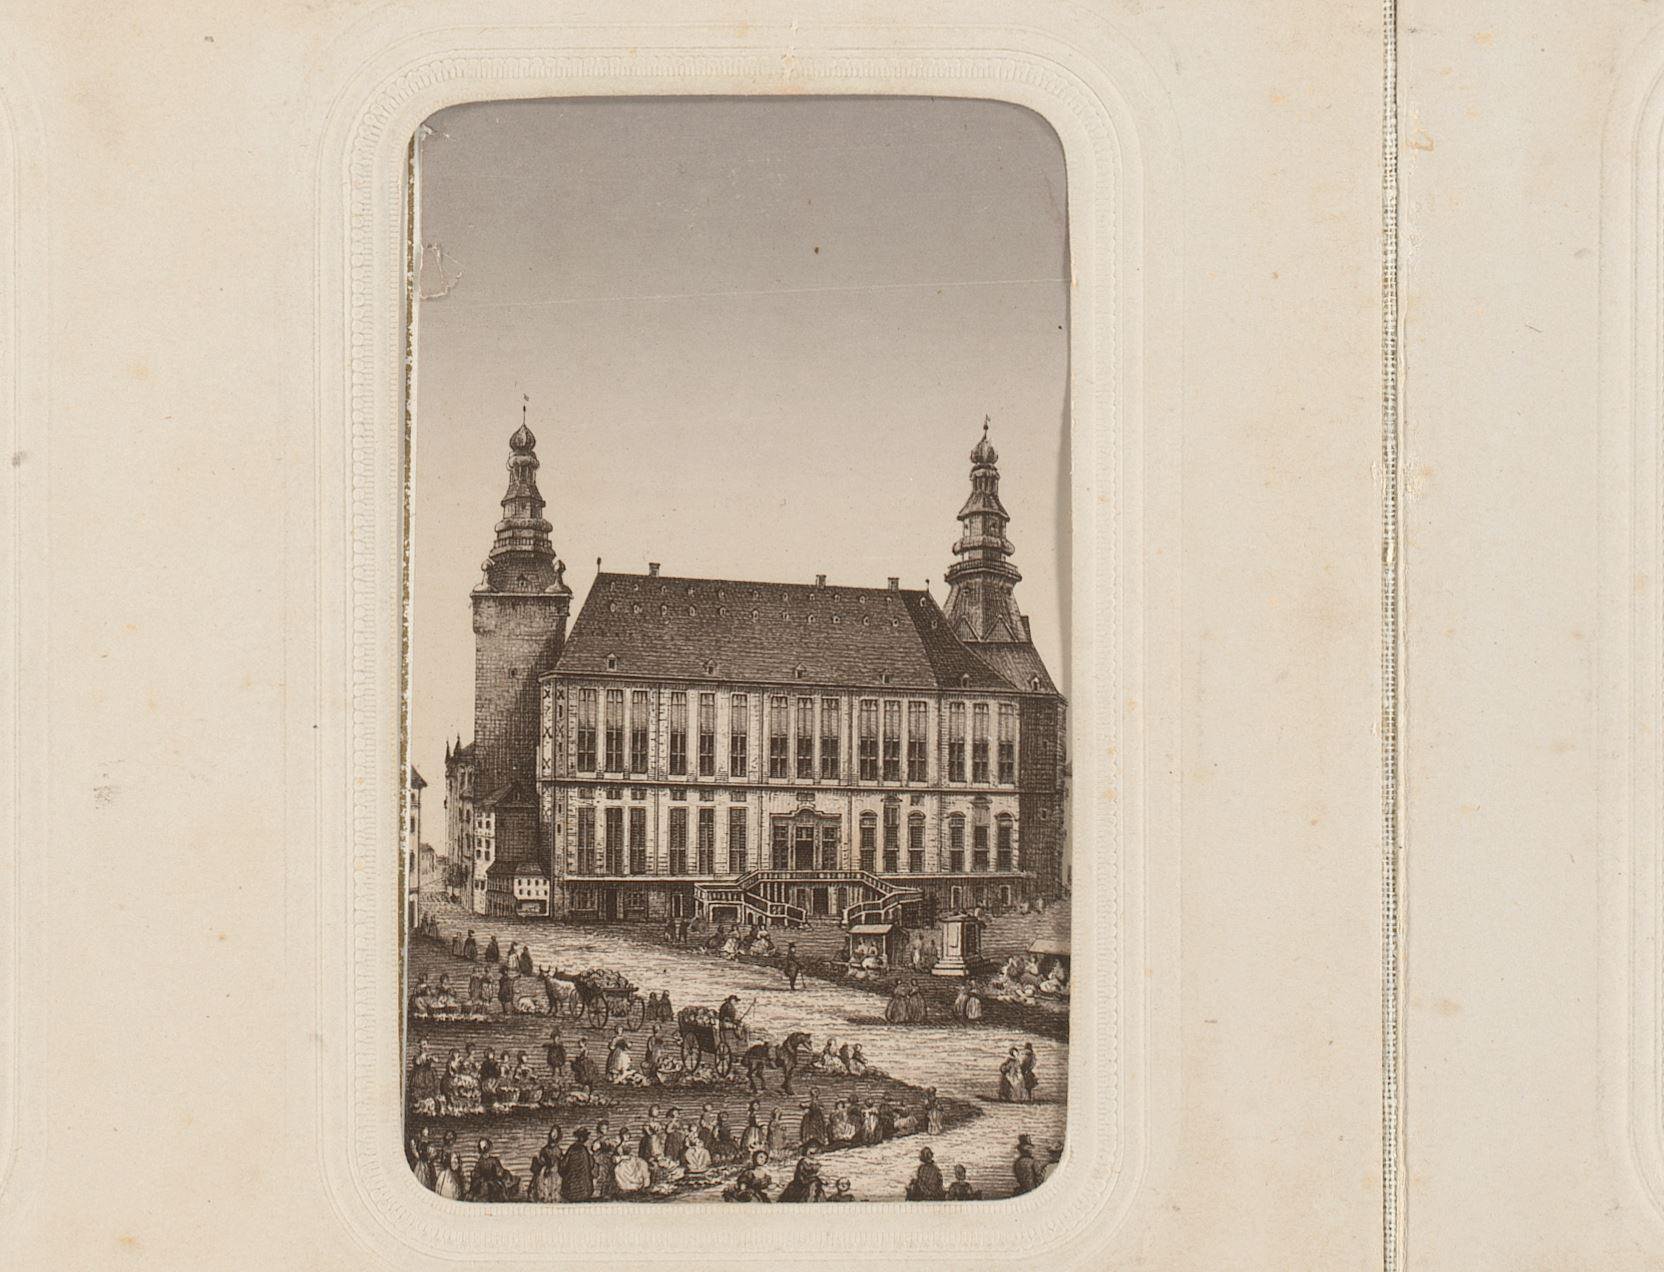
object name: reproduction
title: Aachen, Rathhaus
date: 1860-1885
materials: cardboard, photographic support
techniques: collodion silver print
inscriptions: annotation: ‘Aken/ Rathhaus’, annotation: ‘Aken/ Rathhaus’